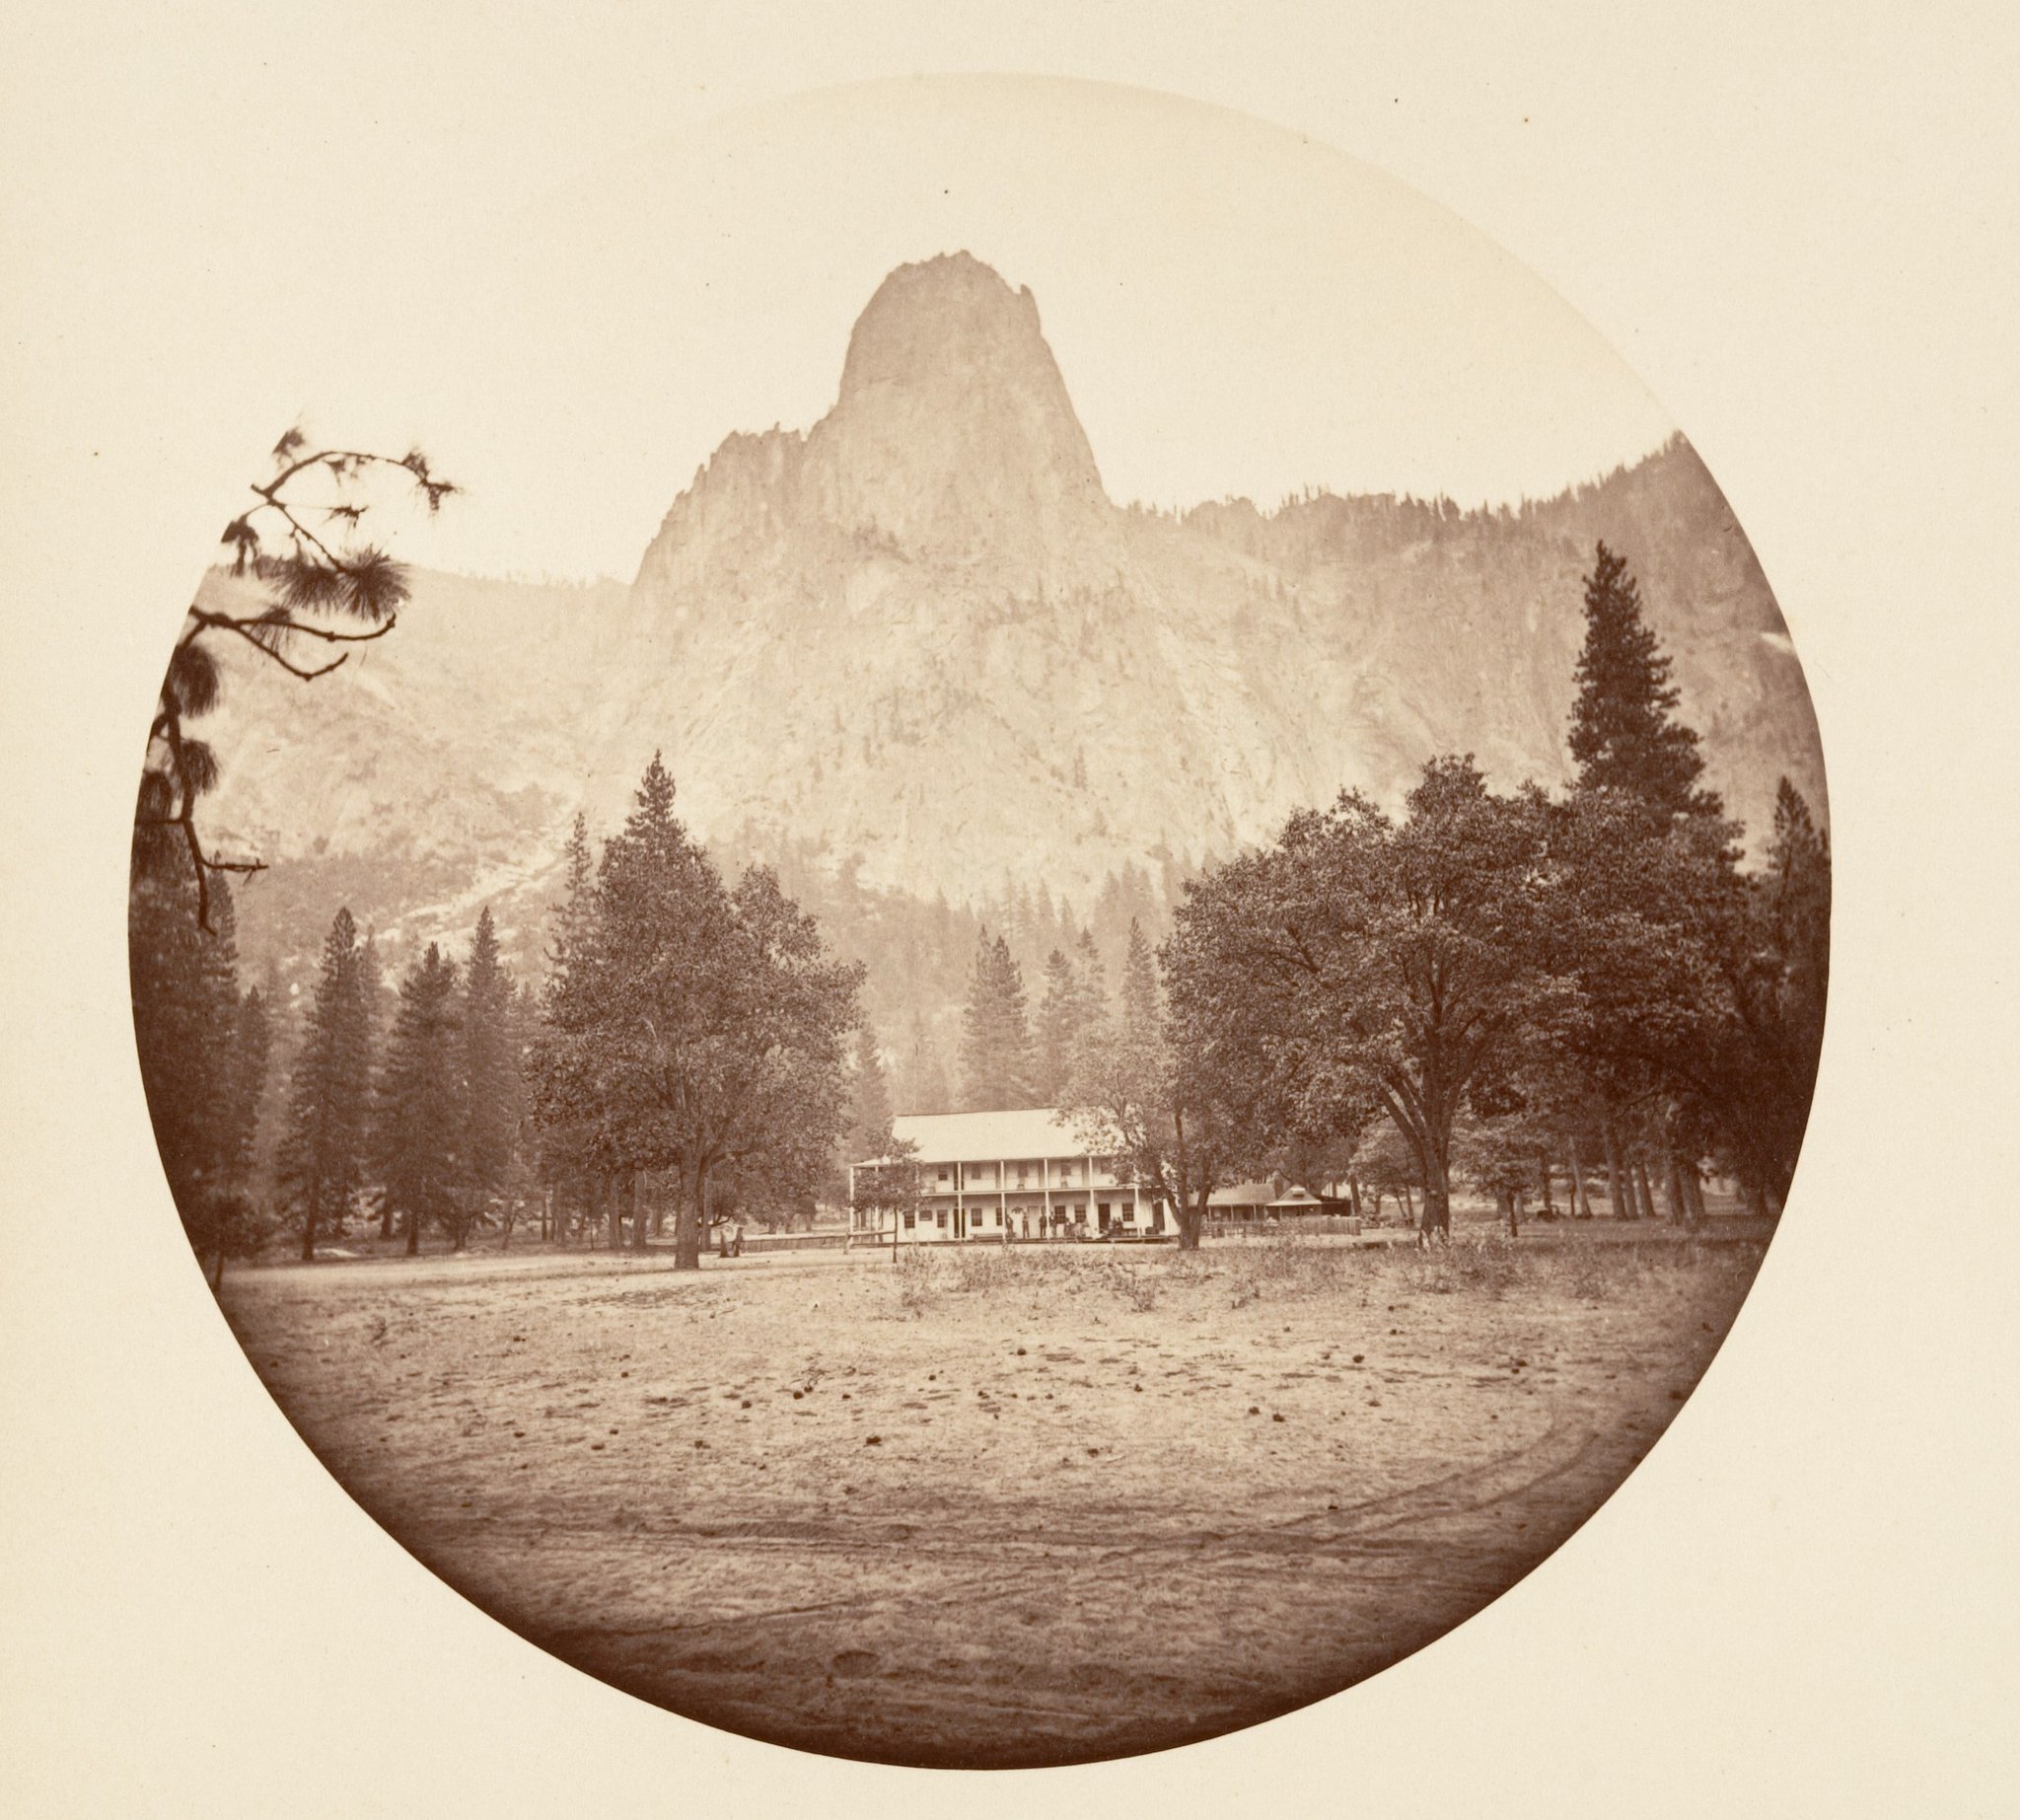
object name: photograph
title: [Yosemite National Park, California]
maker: carleton e. watkins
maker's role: artist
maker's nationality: american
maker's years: 1829-1916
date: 1878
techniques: albumen silver print, glass negative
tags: mountains,landscapes